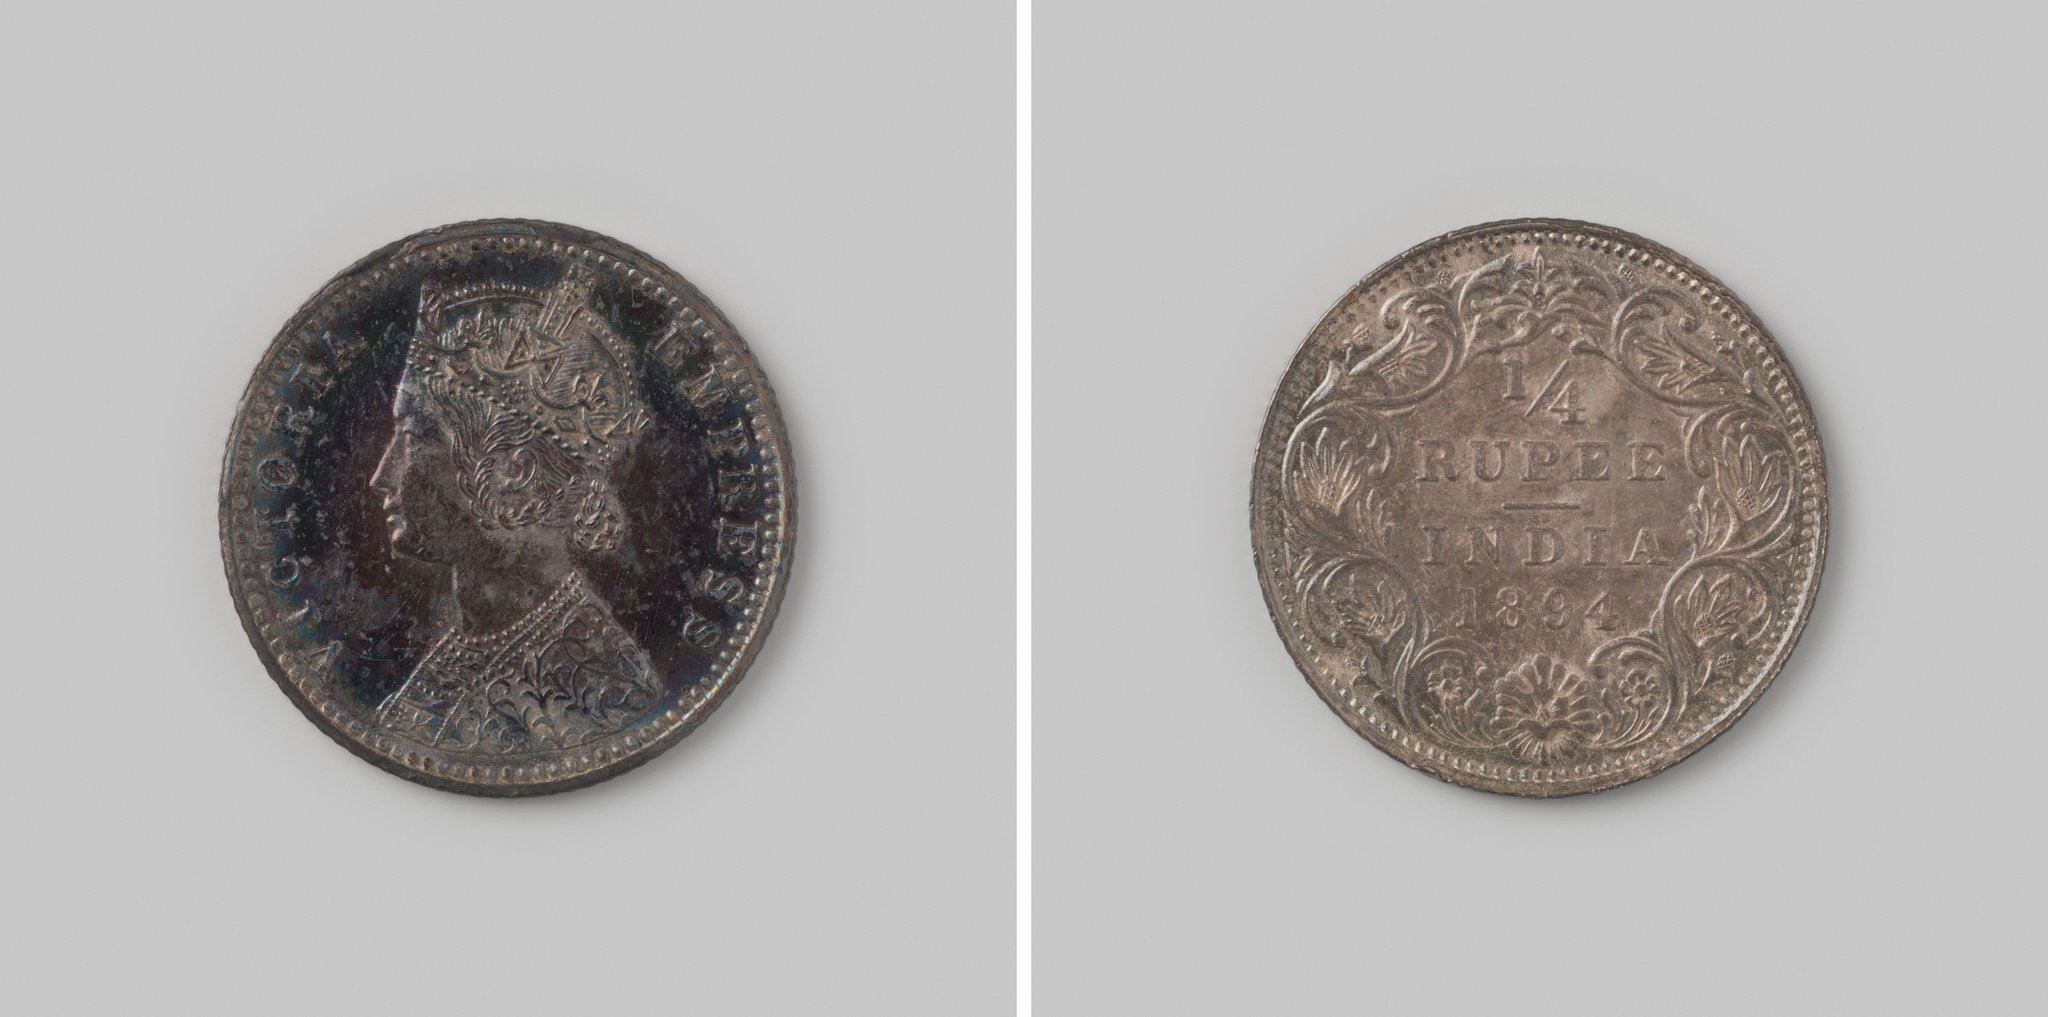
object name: coin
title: 1/4 roepie uit India van keizerin Victoria, 1894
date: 1894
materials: silver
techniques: striking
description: Zilveren munt. Voorzijde: gekroond borstbeeld van koningin Victoria naar links. Keerzijde: binnen een kring van lotusbloemen in twee regels waarde-aanduiding: 1/4 rupee, waaronder lands-aanduiding. Daaronder jaartal. Kartelrand.